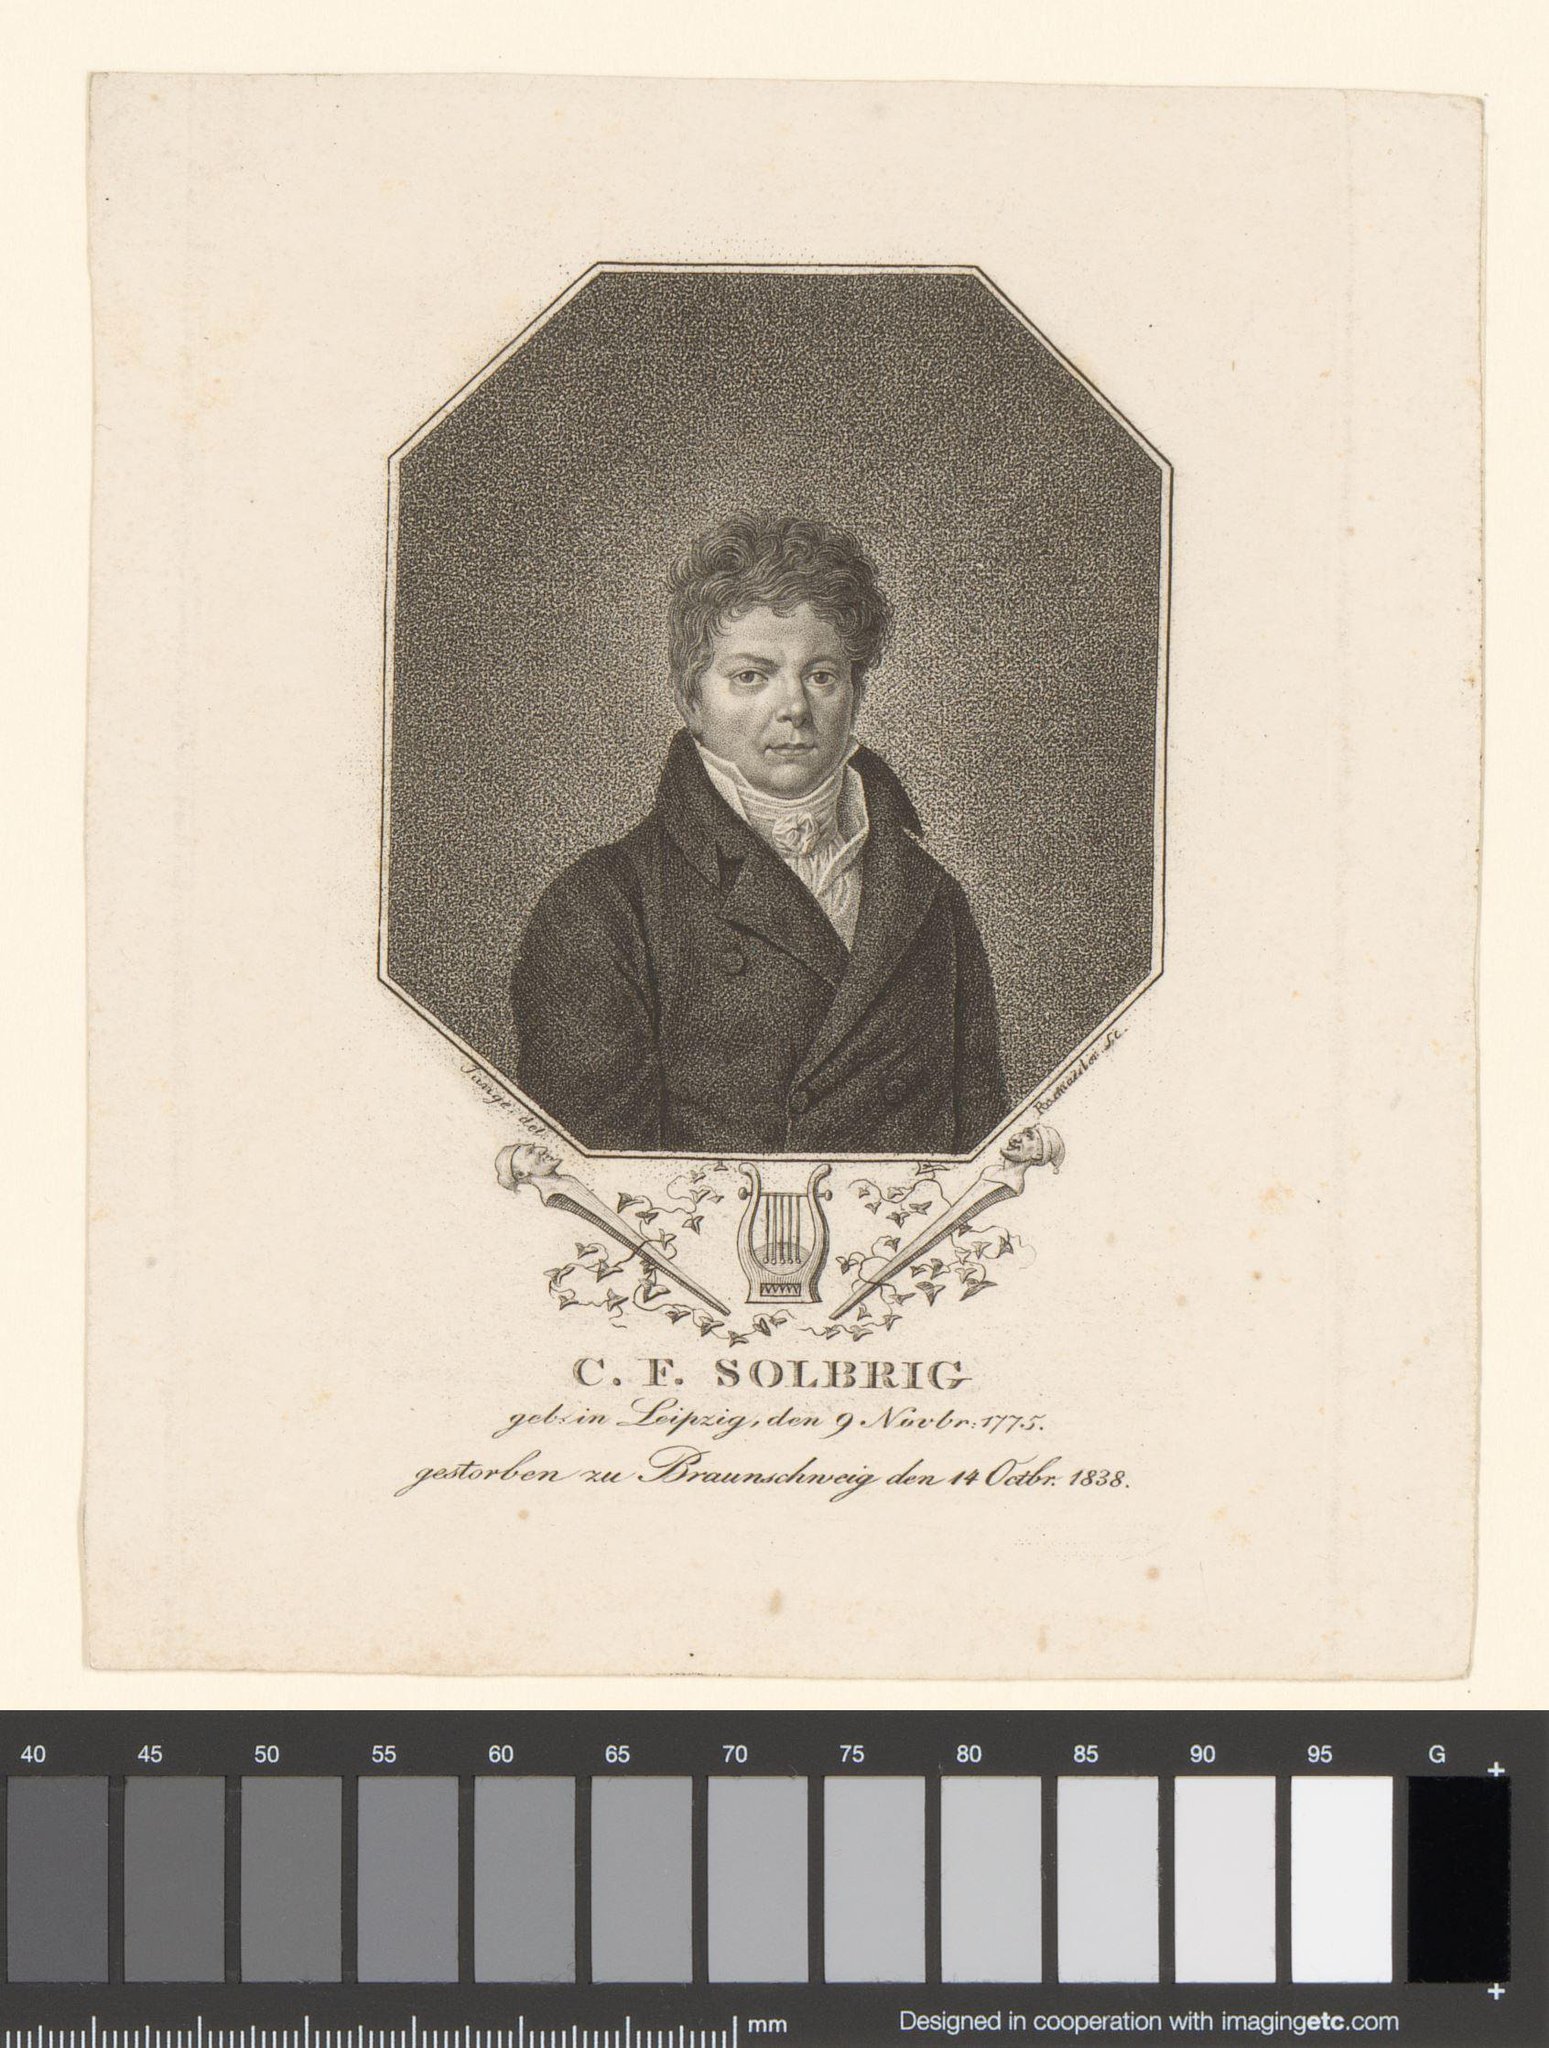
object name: print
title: Portret van Carl Friedrich Solbrig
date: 1838-1858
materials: paper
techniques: engraving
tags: historical persons, portrait of actor, actress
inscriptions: collector's mark: Lugt 2228